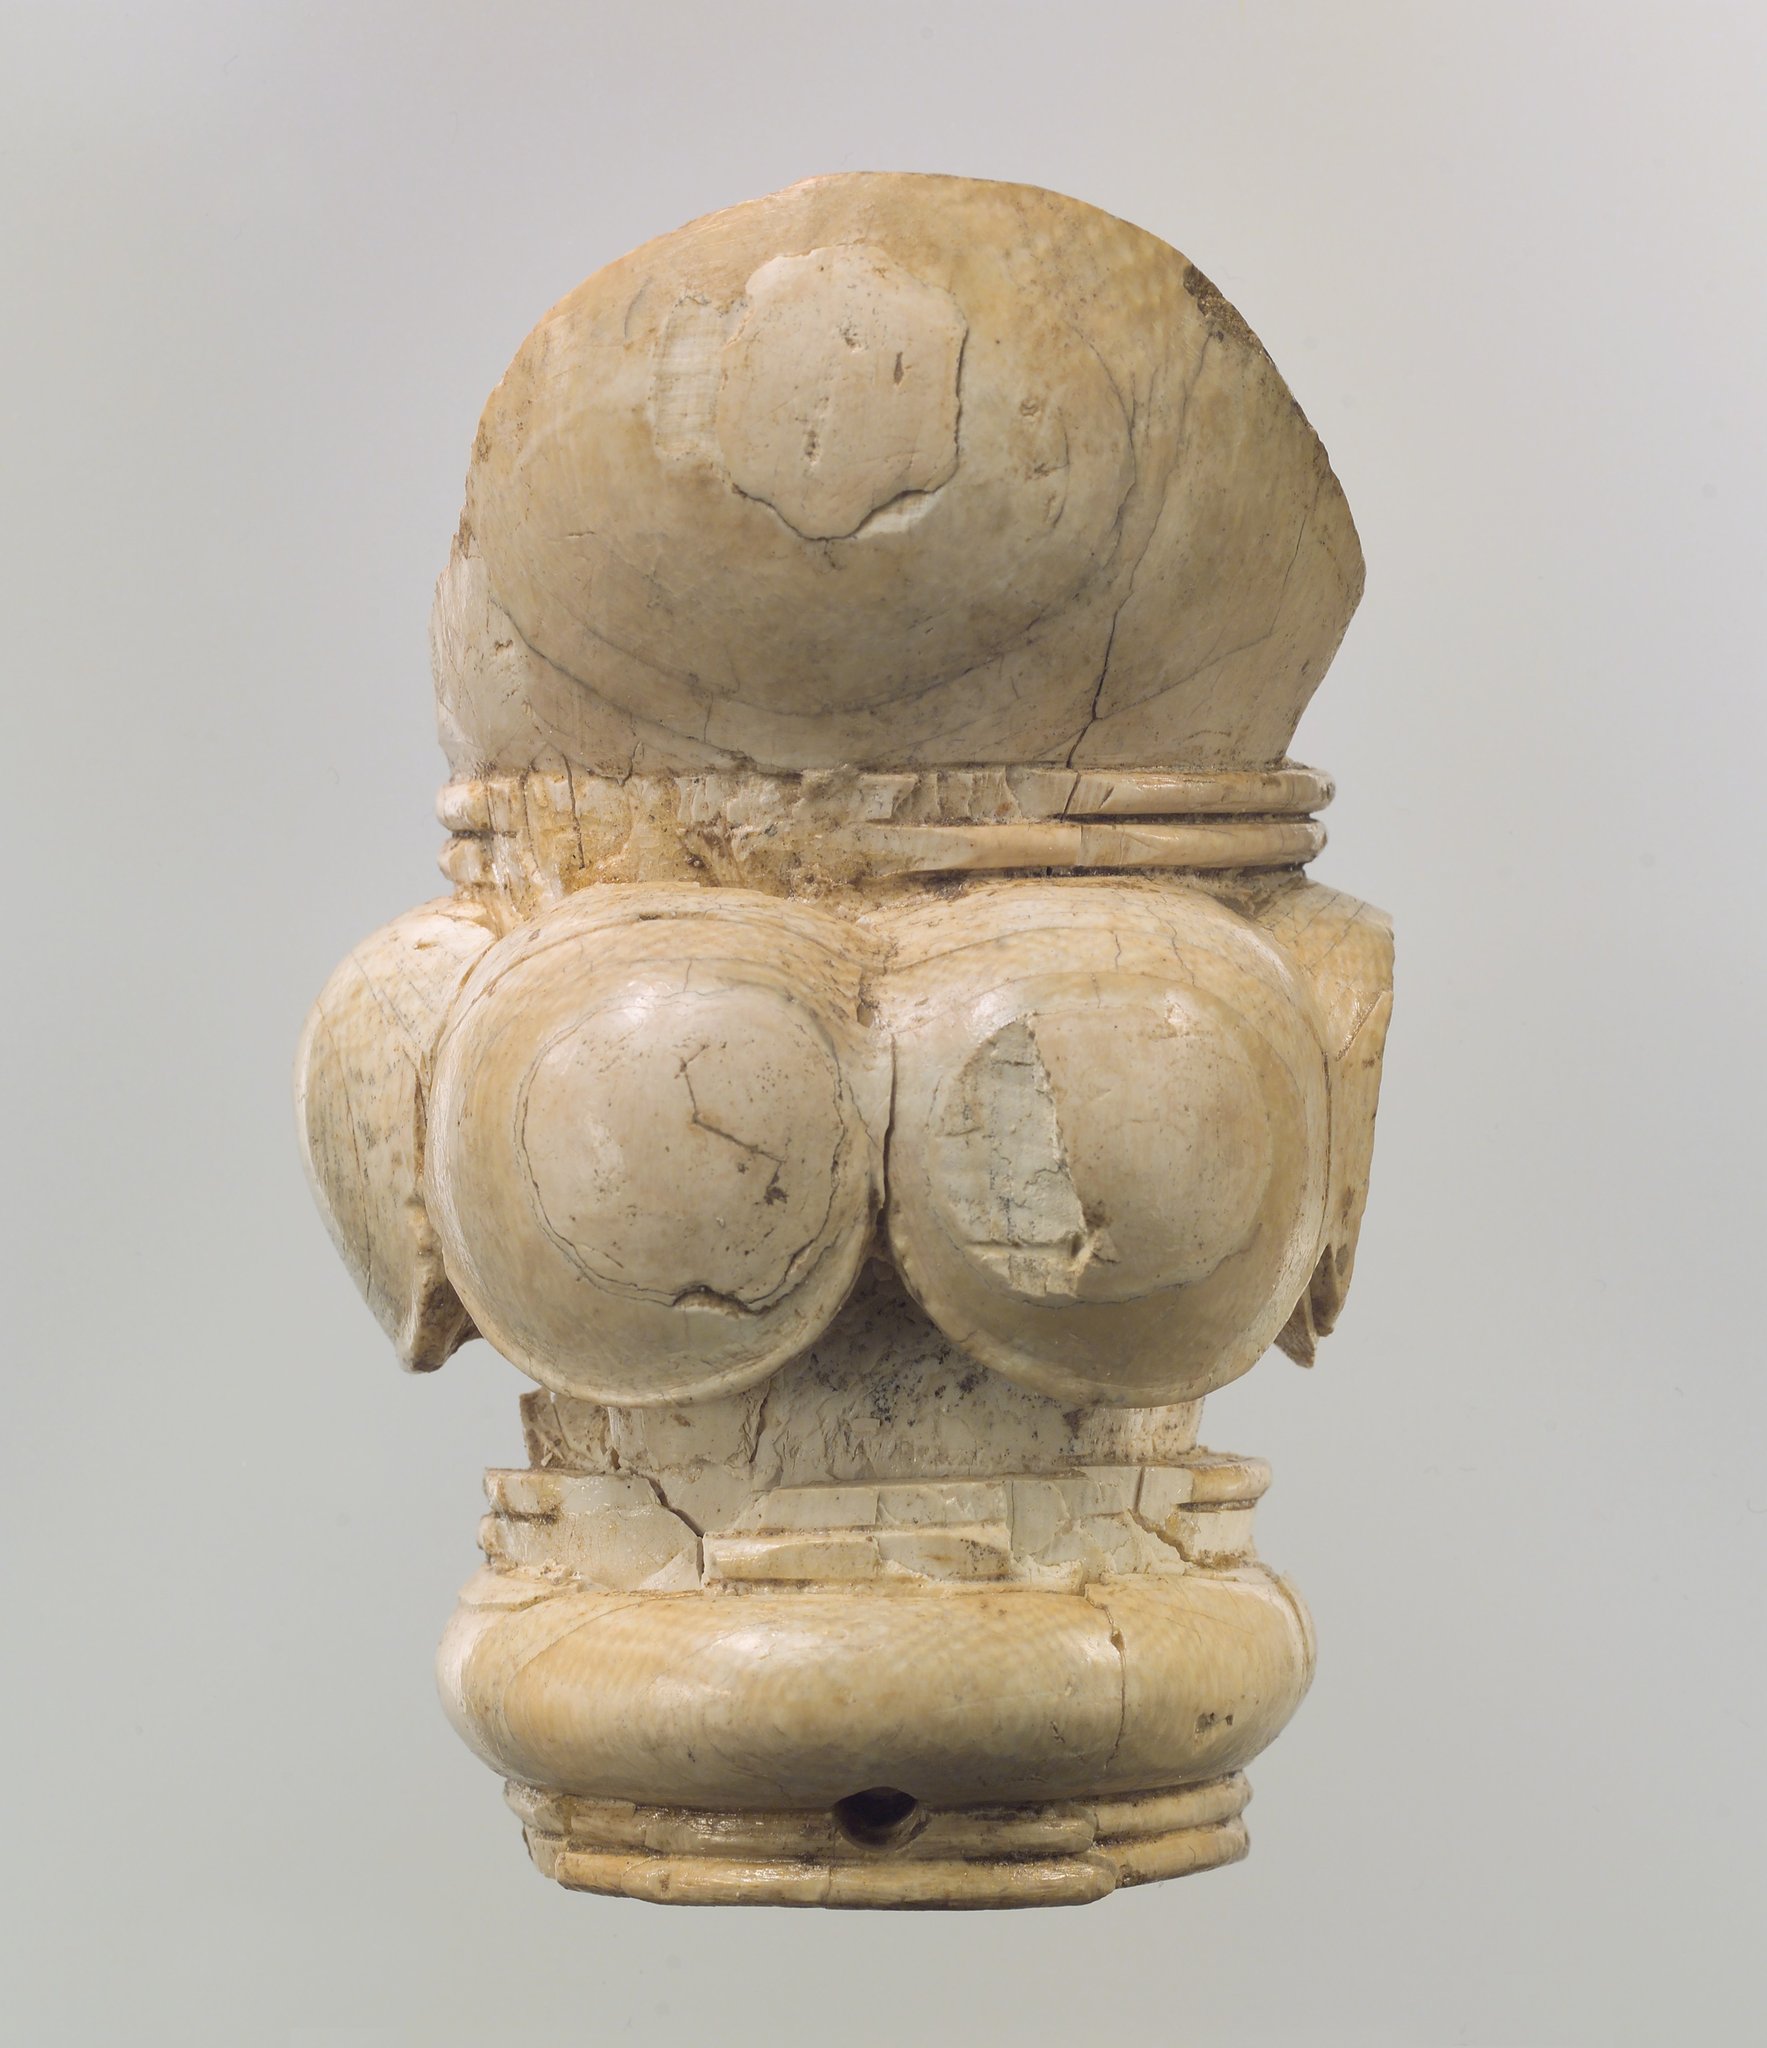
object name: furniture element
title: Furniture element carved in the round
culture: assyrian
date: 900-701 BCE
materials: ivory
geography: syria